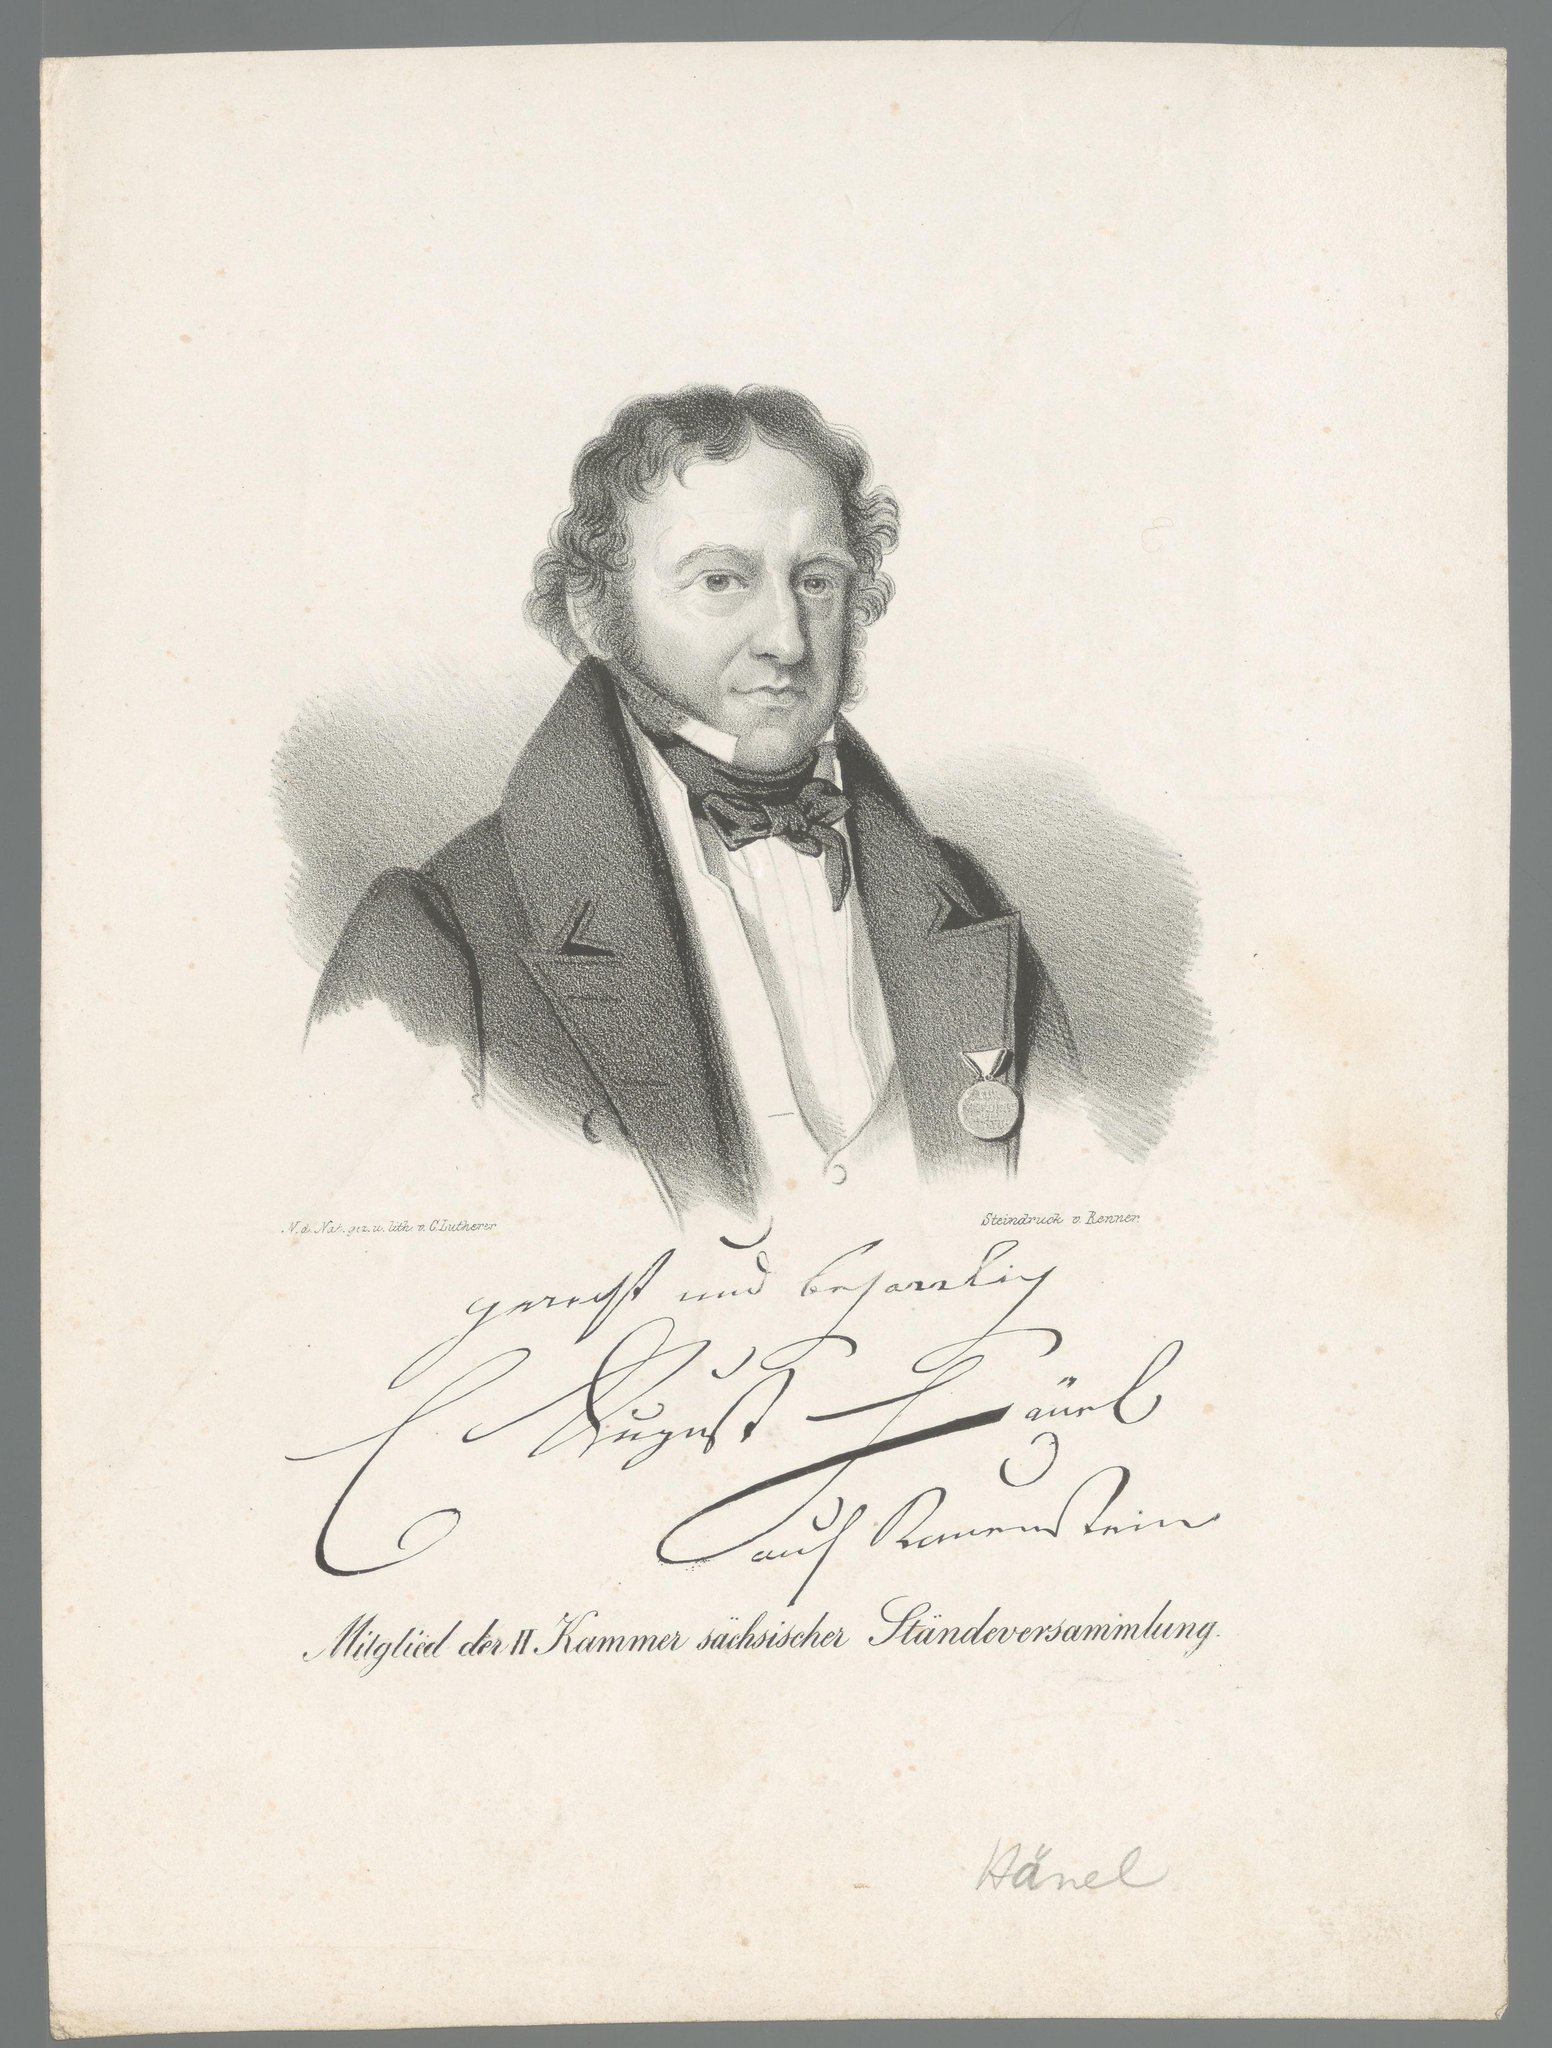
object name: print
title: Portret van Christian August Hänel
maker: carl lutherer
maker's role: draughtsman, print maker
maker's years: 1807-1850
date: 1817-1850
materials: paper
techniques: lithograph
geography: dresden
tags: politician, e.g. party leader, historical persons not known by name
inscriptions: collector's mark: Lugt 2228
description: Portret van een verder onbekende politicus met de naam Christian August Hänel.